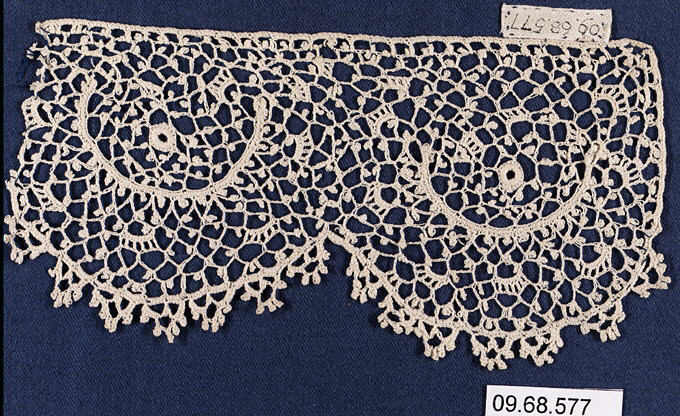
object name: specimen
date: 1801-1900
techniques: crochet